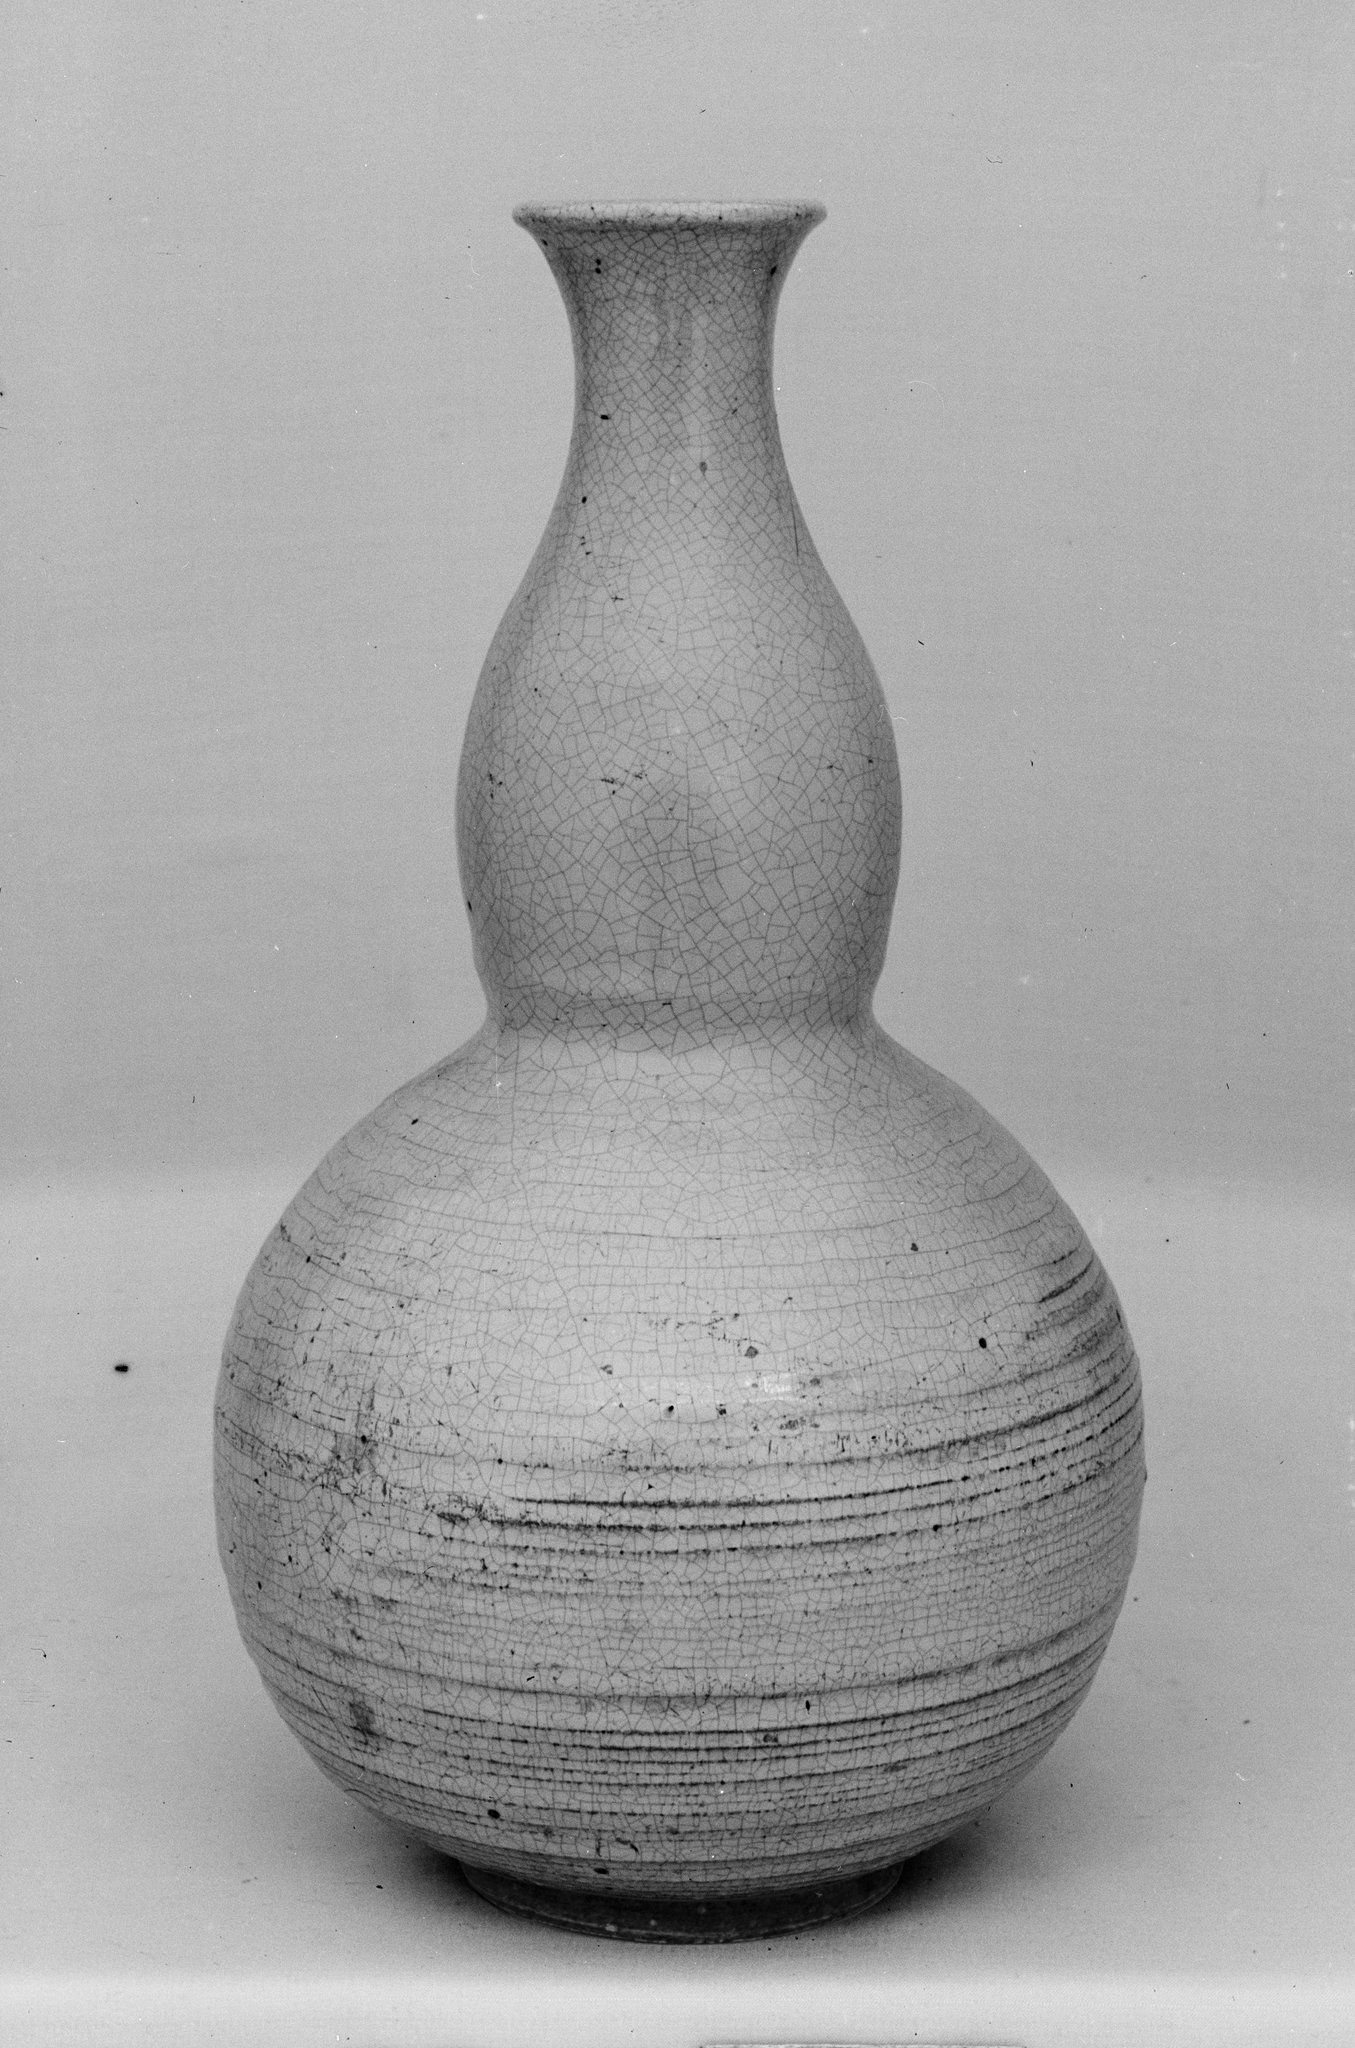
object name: bottle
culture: japanese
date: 1701-1800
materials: glaze, paste